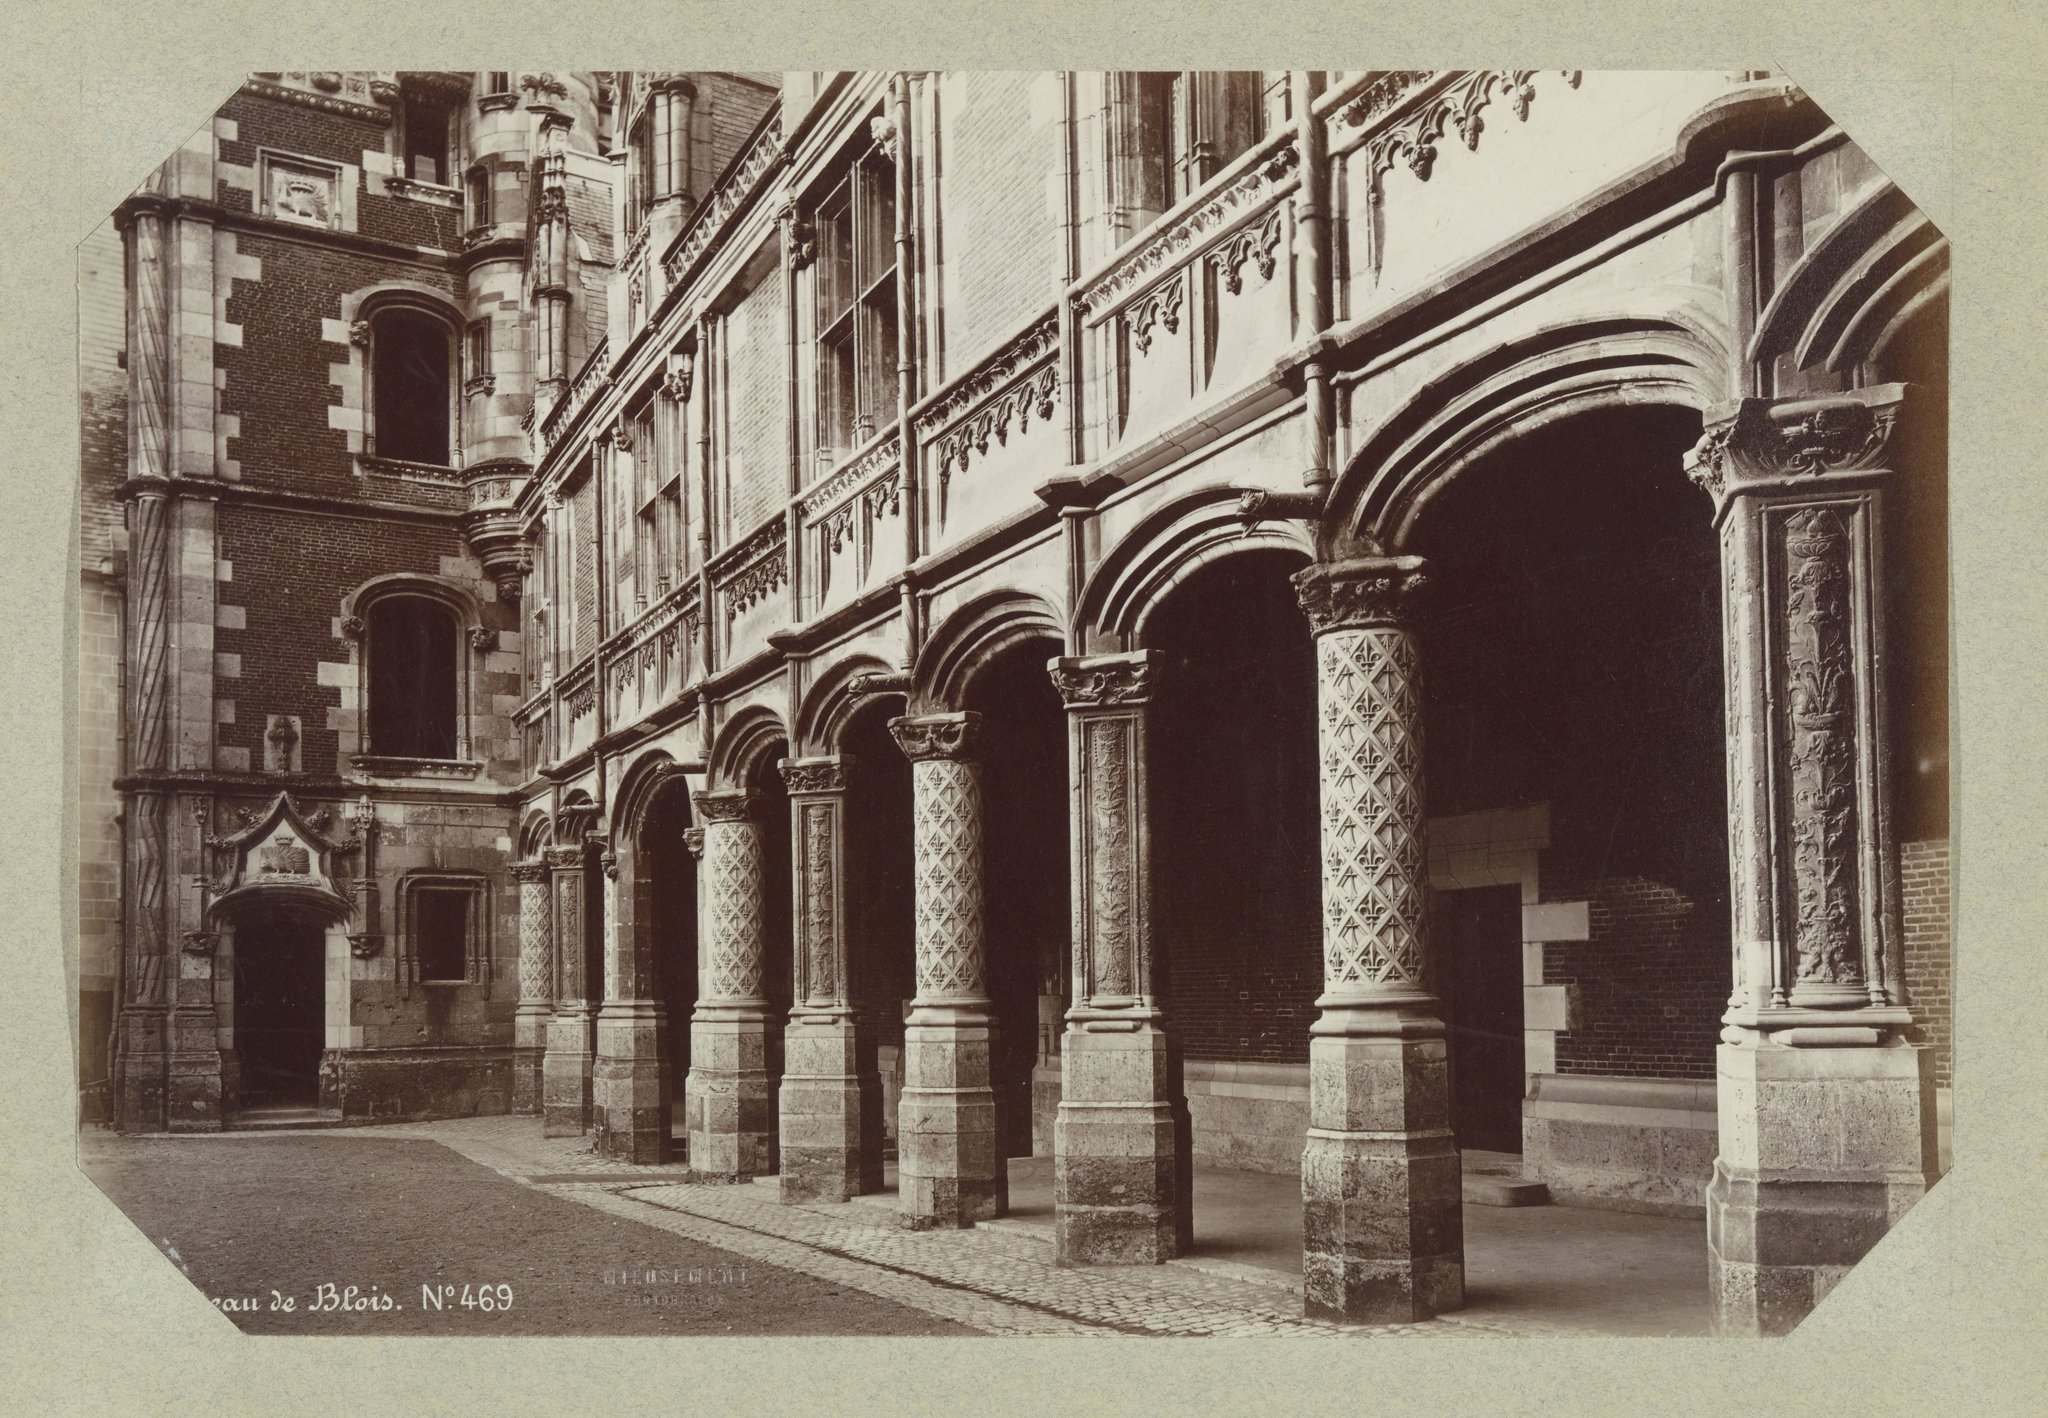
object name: photograph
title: [(...)]eau de Blois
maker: séraphin-médéric mieusement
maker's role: fotograaf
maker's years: 1840-1905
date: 1880-1900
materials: photographic support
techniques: albumen print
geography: blois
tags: colonnade, castle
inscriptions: inscription: ‘Monuments Historiques’, number: ‘469’, name: ‘Mieusement photographe’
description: Onderdeel van Fotoalbum met opnames van monumenten in Frankrijk.